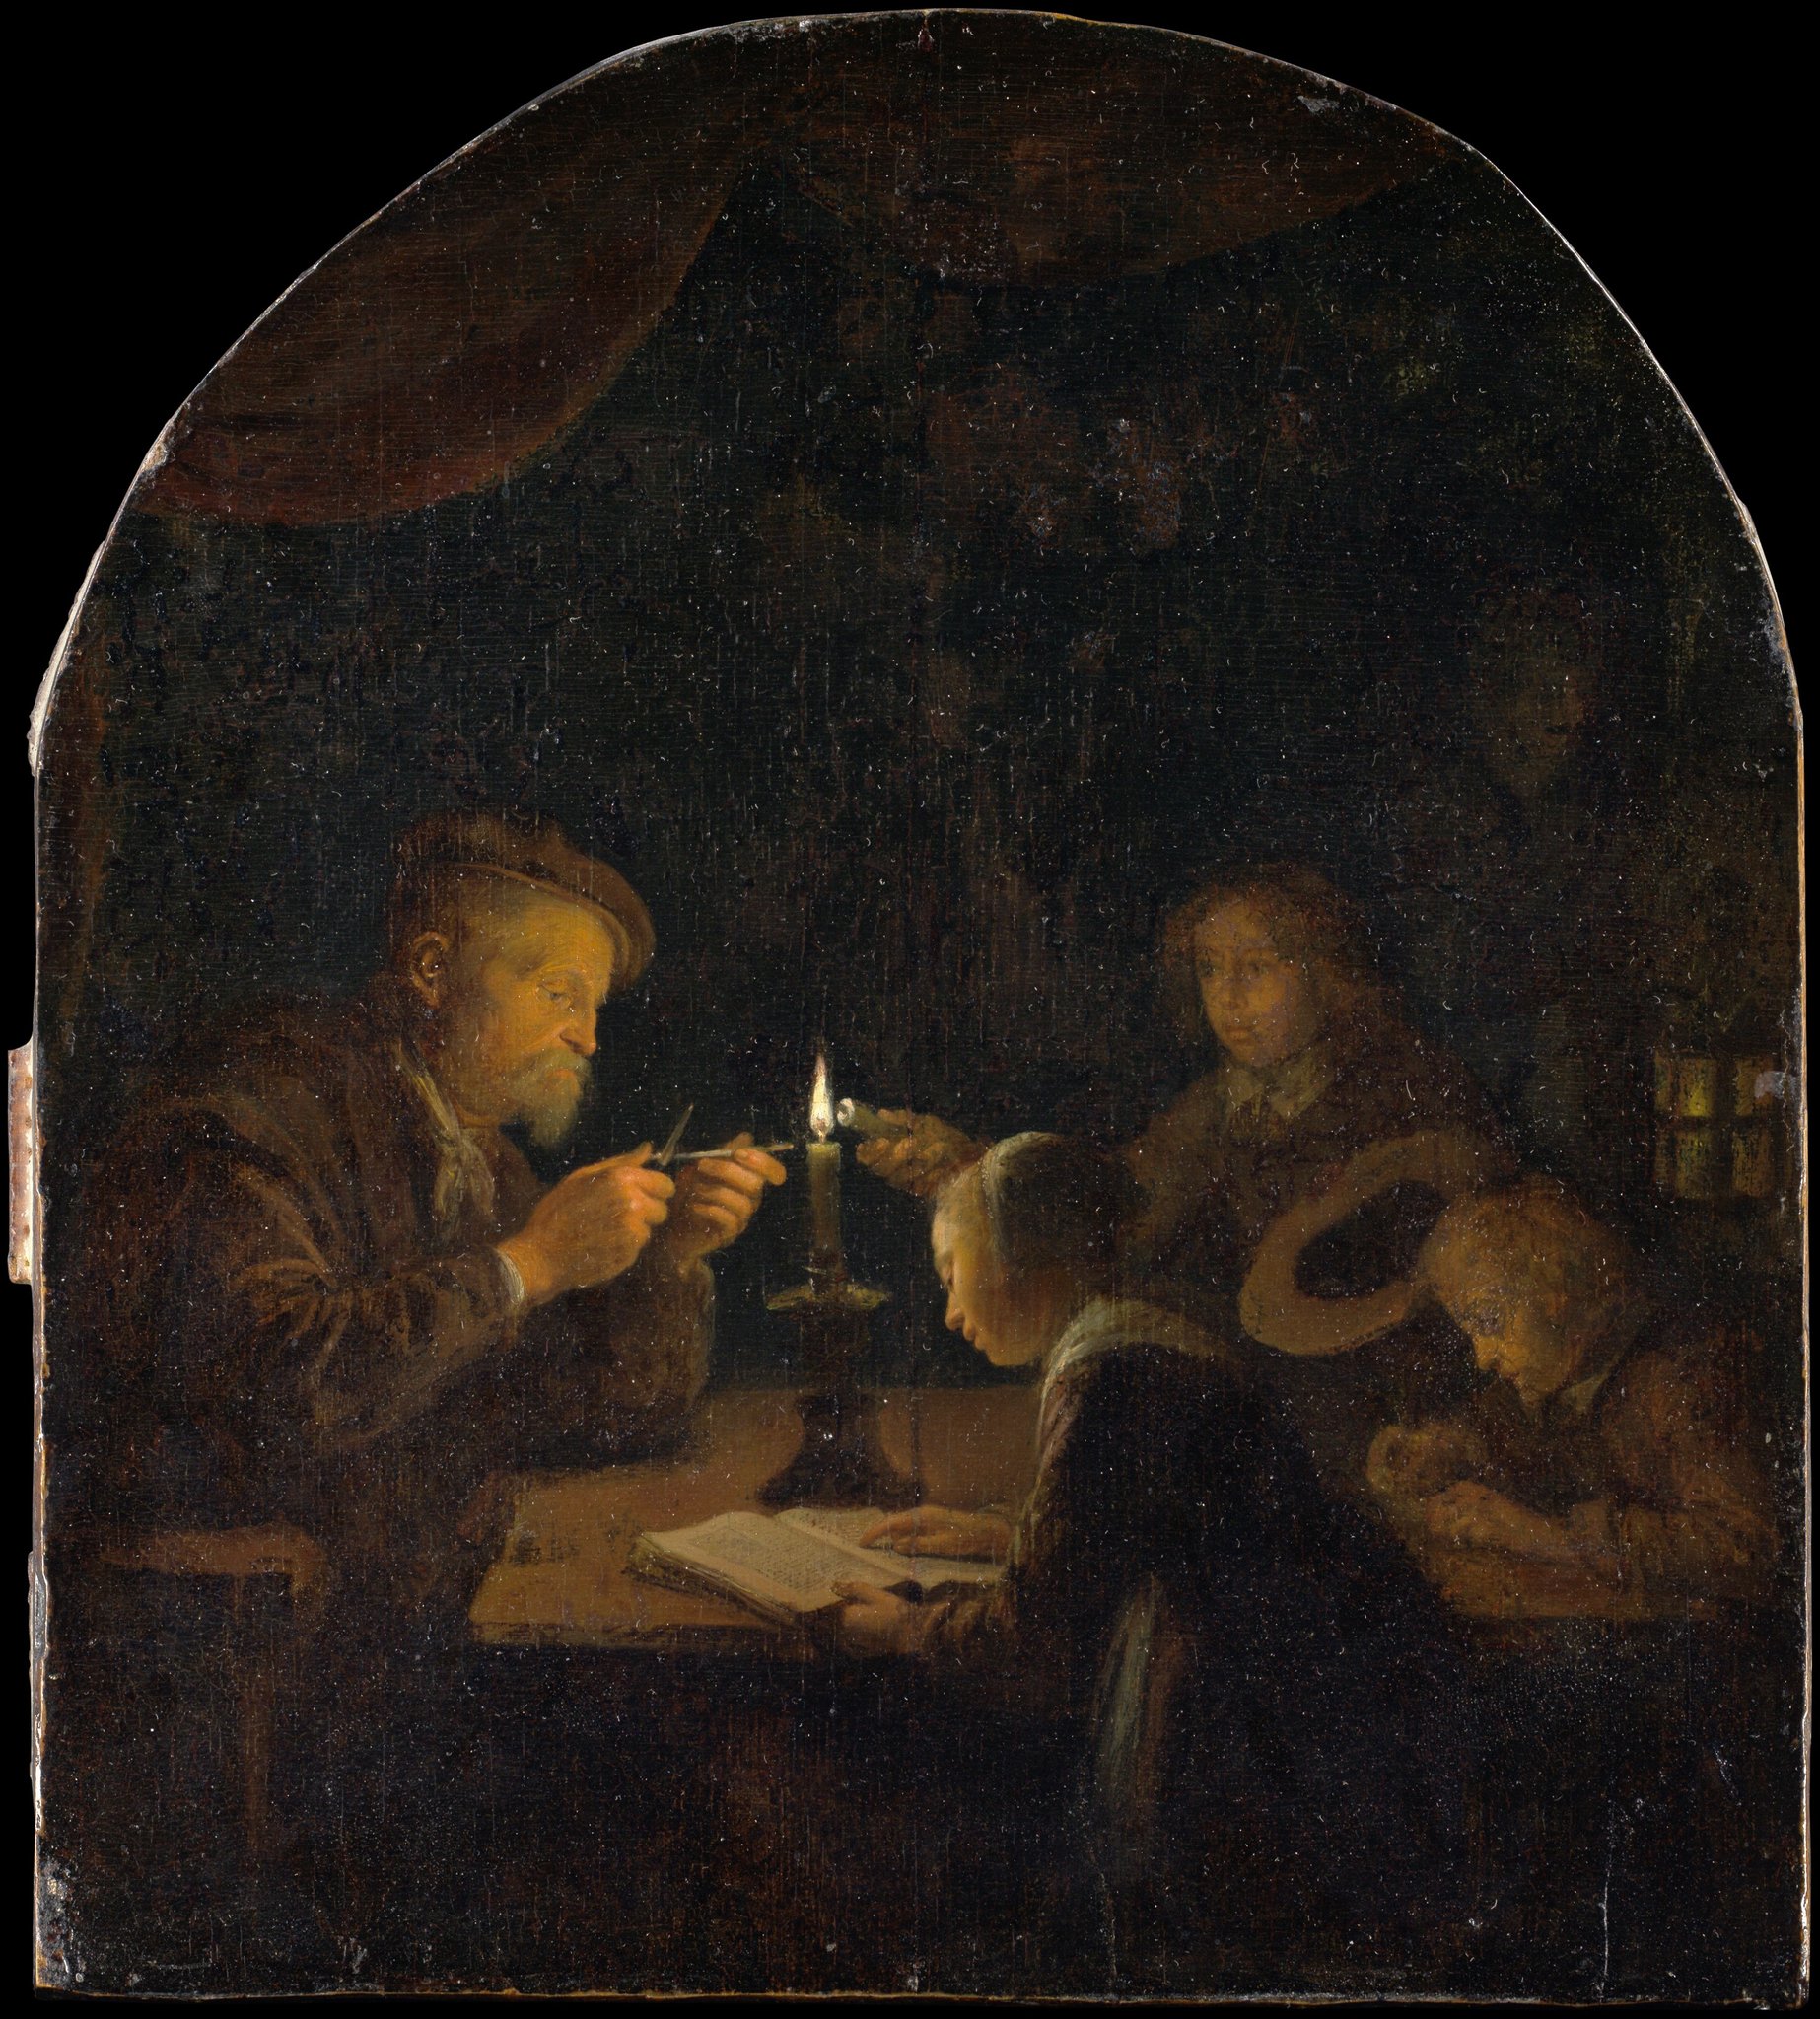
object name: painting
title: An Evening School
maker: gerrit dou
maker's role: artist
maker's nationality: dutch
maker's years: 1613-1675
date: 1655-1657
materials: oil, wood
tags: boys,girls,men,reading,students,teachers